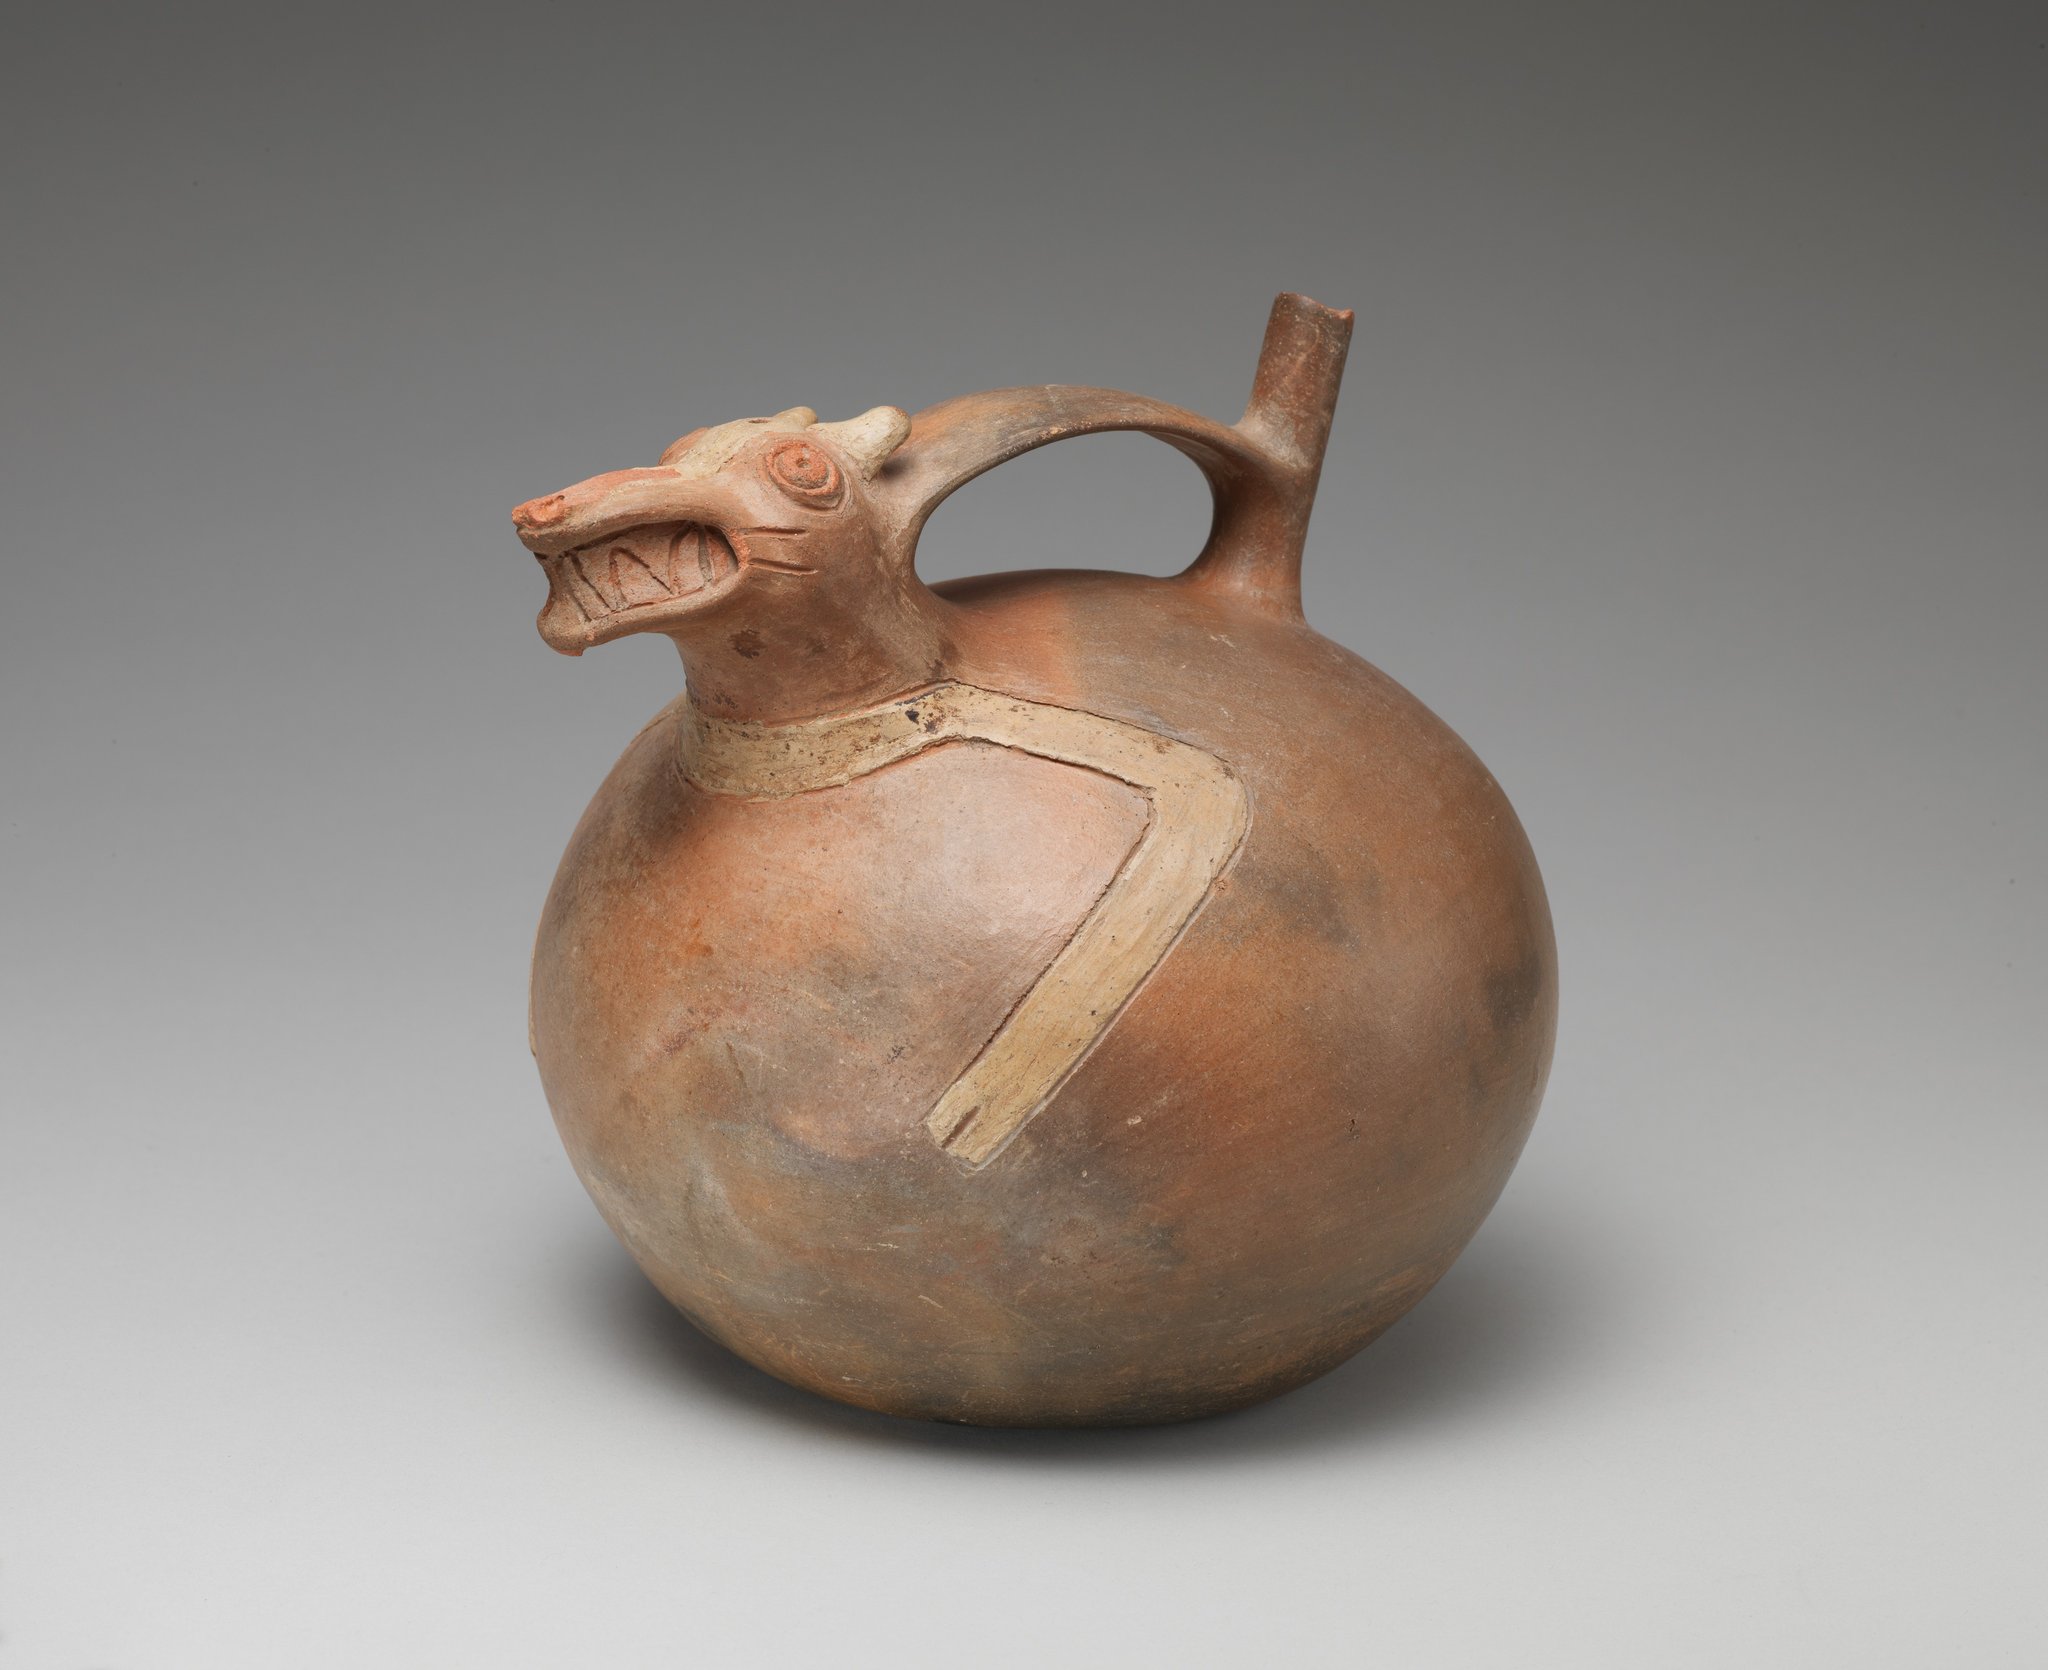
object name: bottle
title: Spout-and-bridge bottle with fox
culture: topará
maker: topará artist(s)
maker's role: artist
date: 200 BCE-100 CE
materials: ceramic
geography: peru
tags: foxes